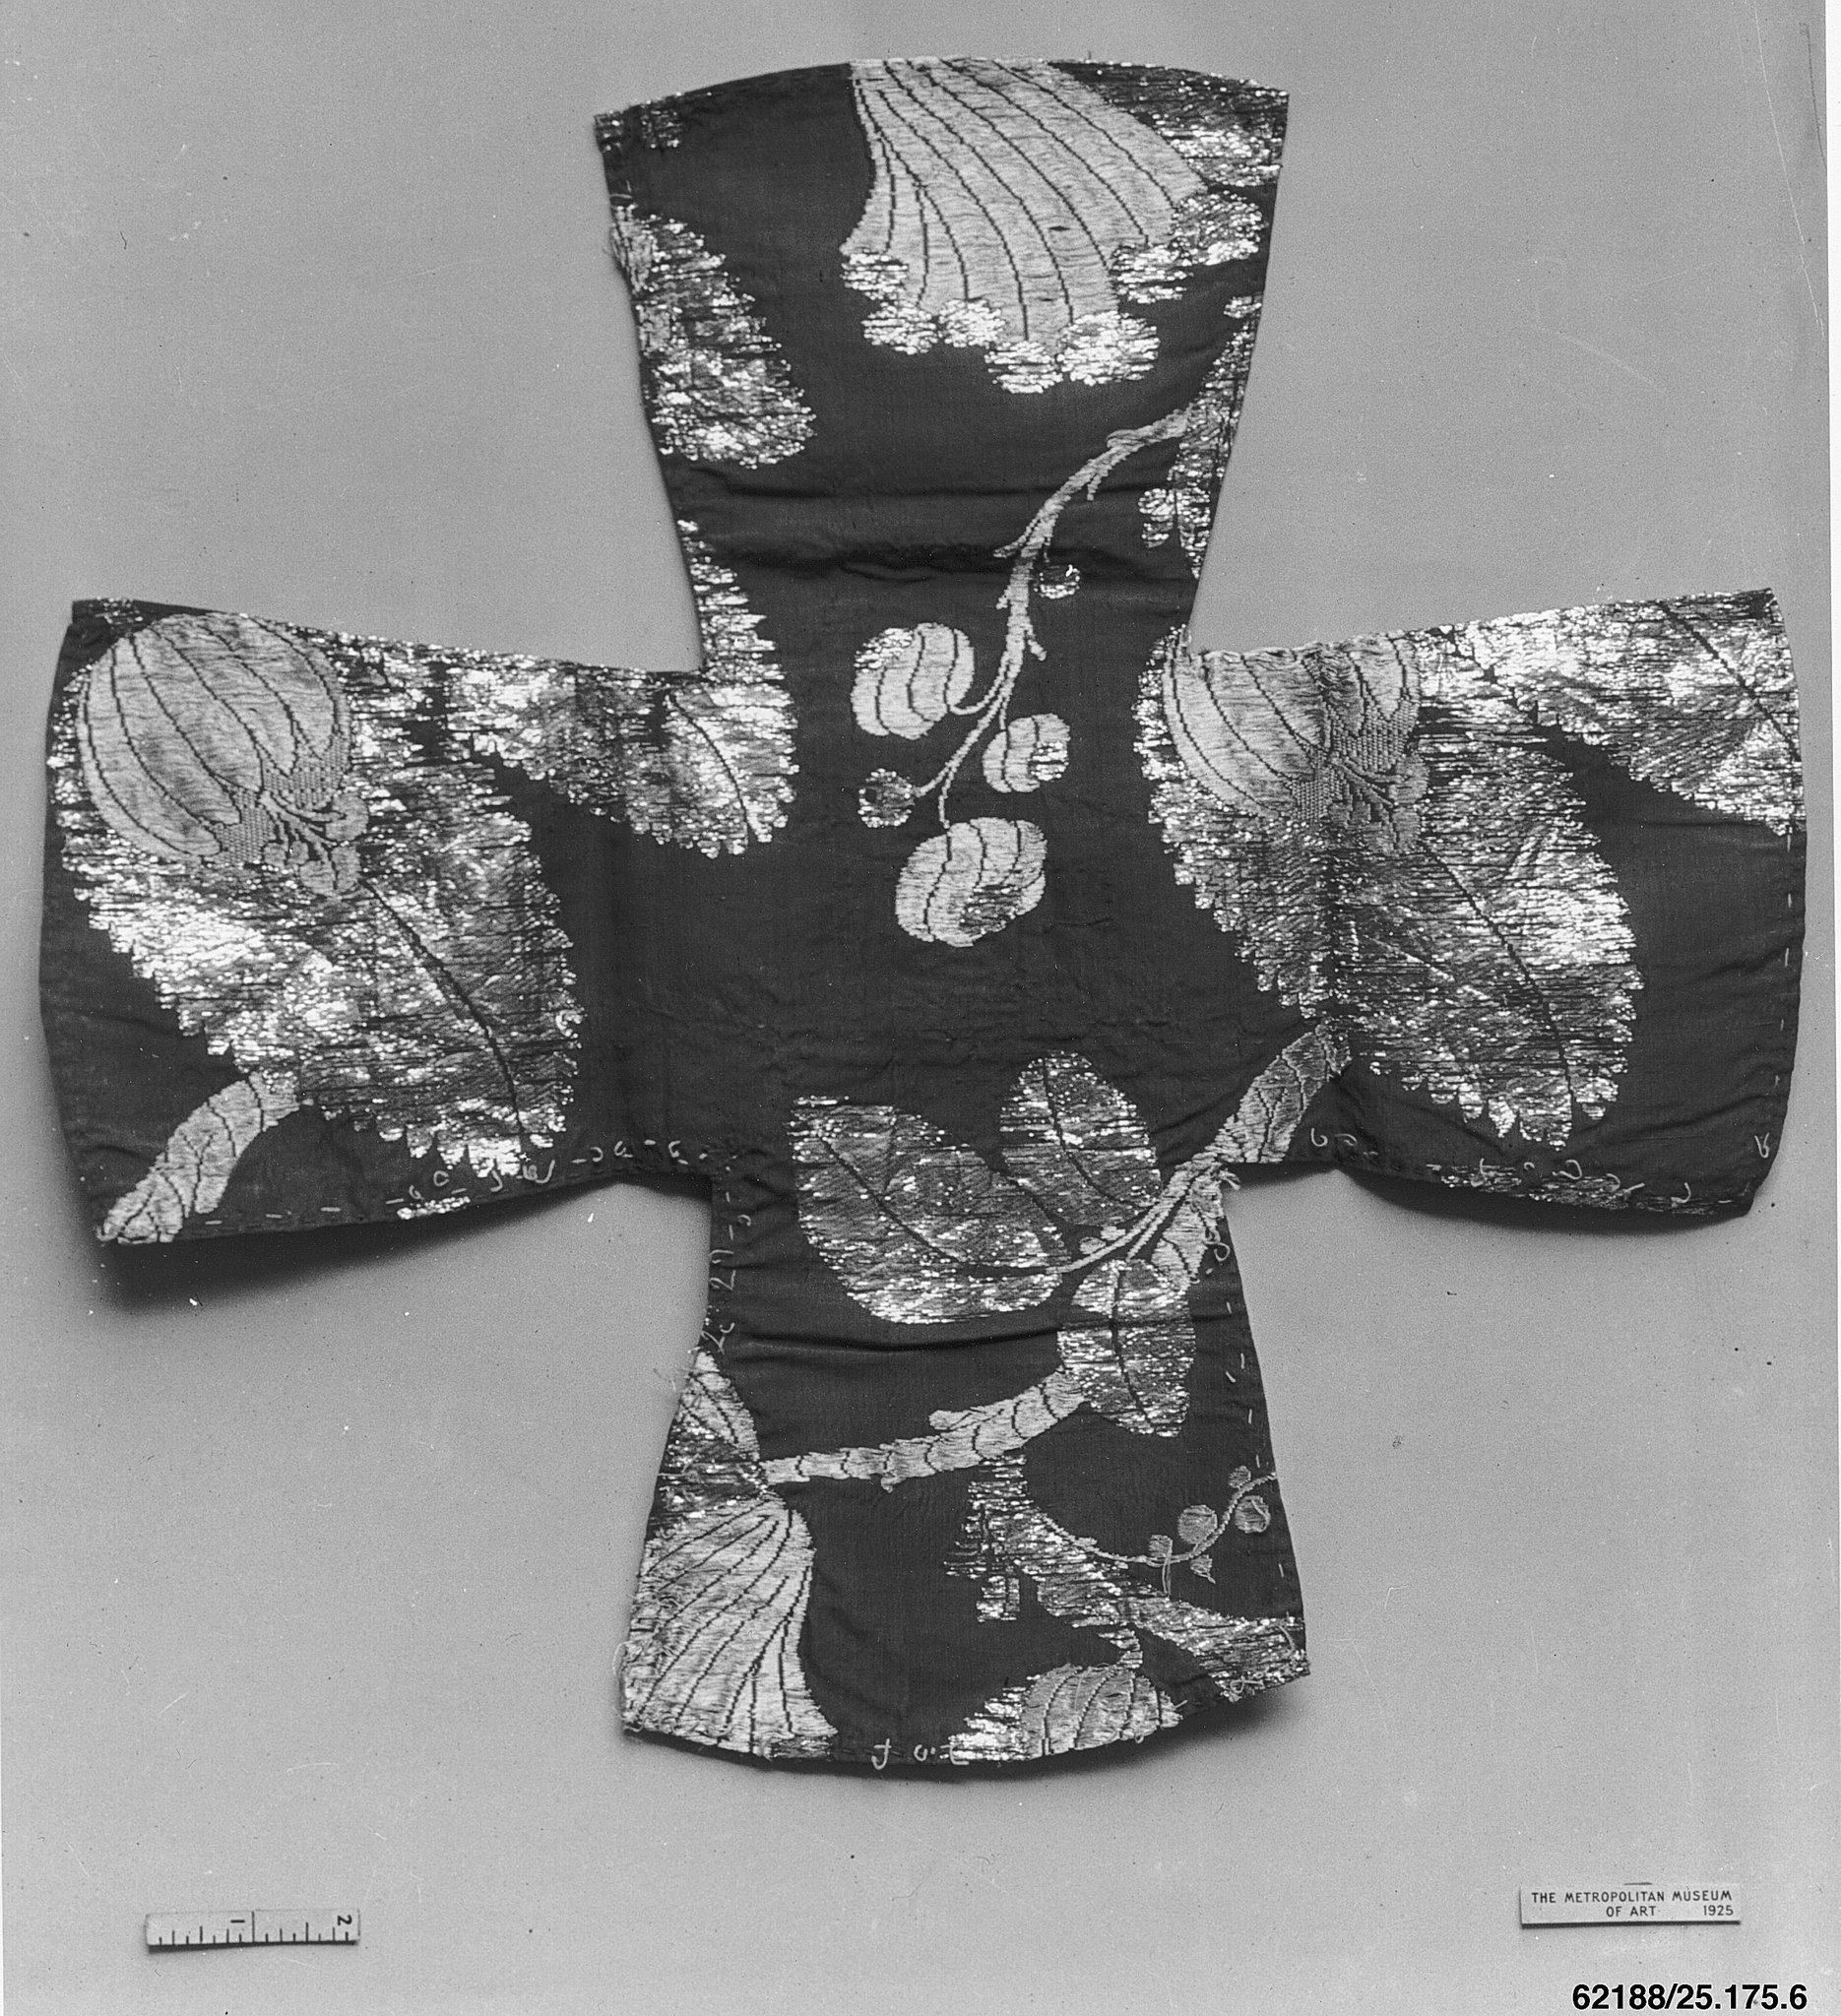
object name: paten veil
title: Paten veil (Diskokalumma)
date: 1701-1800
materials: metal thread, silk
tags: flowers